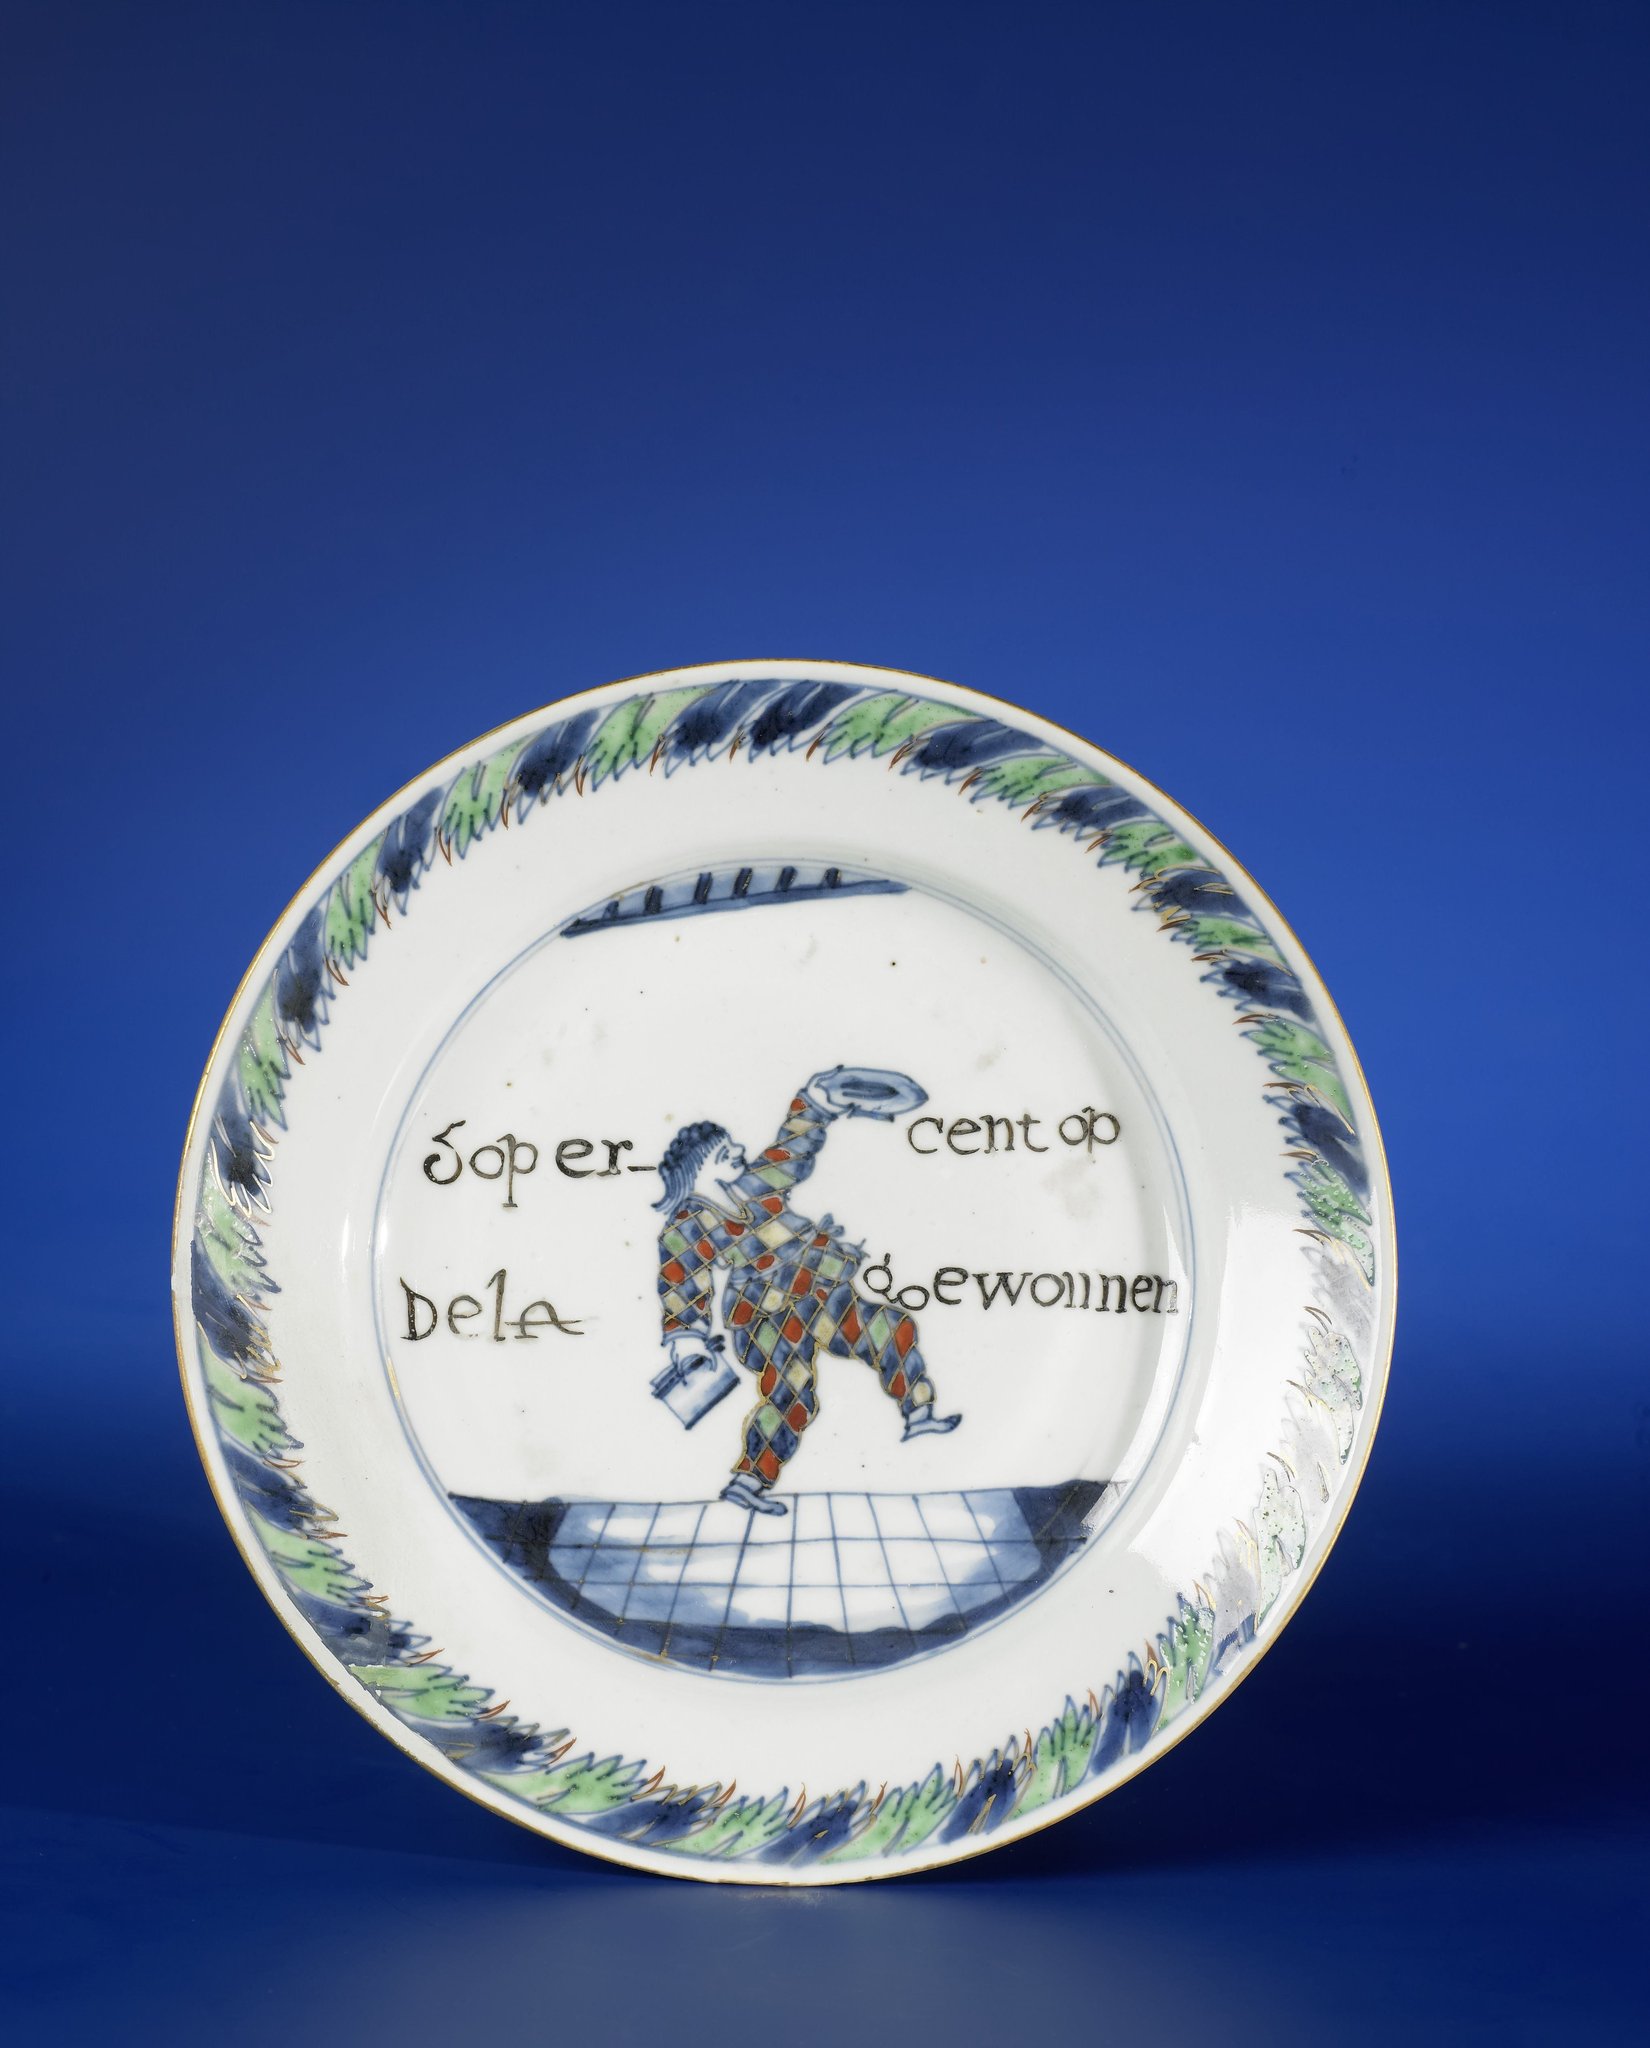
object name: plate dish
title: Plate with a caricatural figure and inscription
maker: Anonymous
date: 1725-1749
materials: cobalt, glaze, gold, paint, porcelain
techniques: firing, gilding, turning, vitrification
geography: china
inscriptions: inscription: ‘50 percent op Delft gewonnen’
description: Bord van porselein, beschilderd in onderglazuur blauw en op het glazuur groen, zwart en goud. Op het plat een harlekijn met de tekst: '50 percent op Delft gewonnen'; de rand met een decoratief patroon. Actie-bord. De rand is gerestaureerd. Europese voorstelling in blauw-wit met emailkleuren.